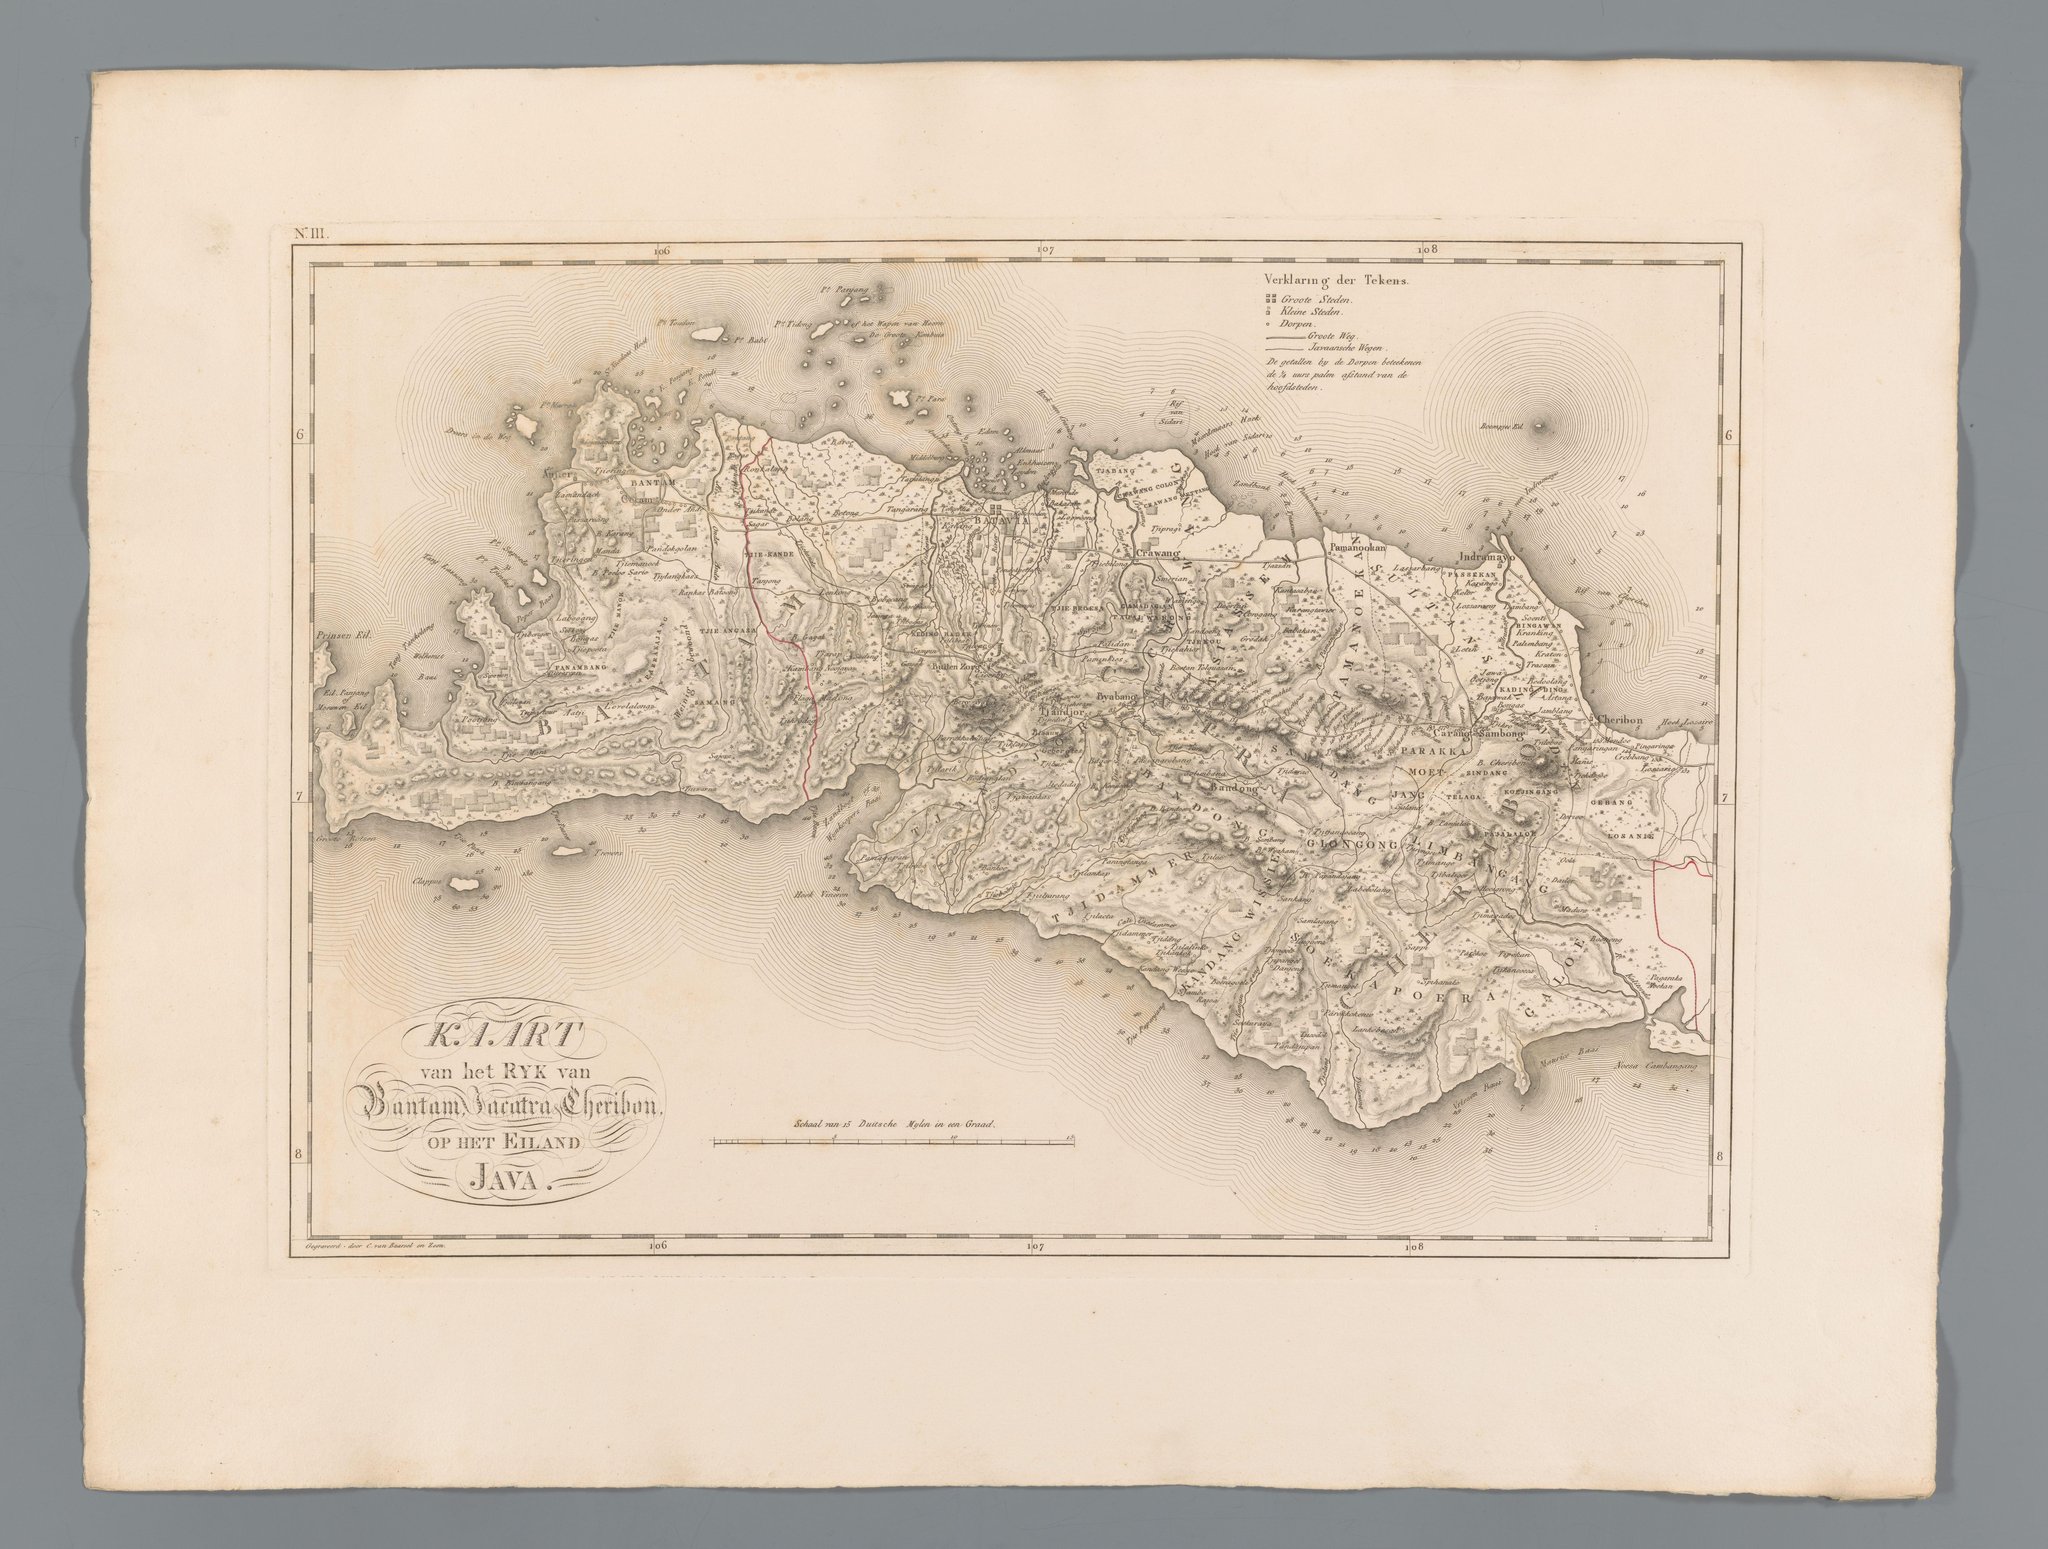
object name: map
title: Kaart van Bantam en West-Java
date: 1818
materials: paper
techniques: engraving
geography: the hague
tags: maps of separate countries or regions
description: Kaart uit: Bosch, Js. van den. Atlas der overzeesche bezittingen van Zijne Majesteit den Koning der Nederlanden, aan hoogst denzelven opgedragen. Den Haag en Amsterdam: Gebroeders van Cleef, 1818.